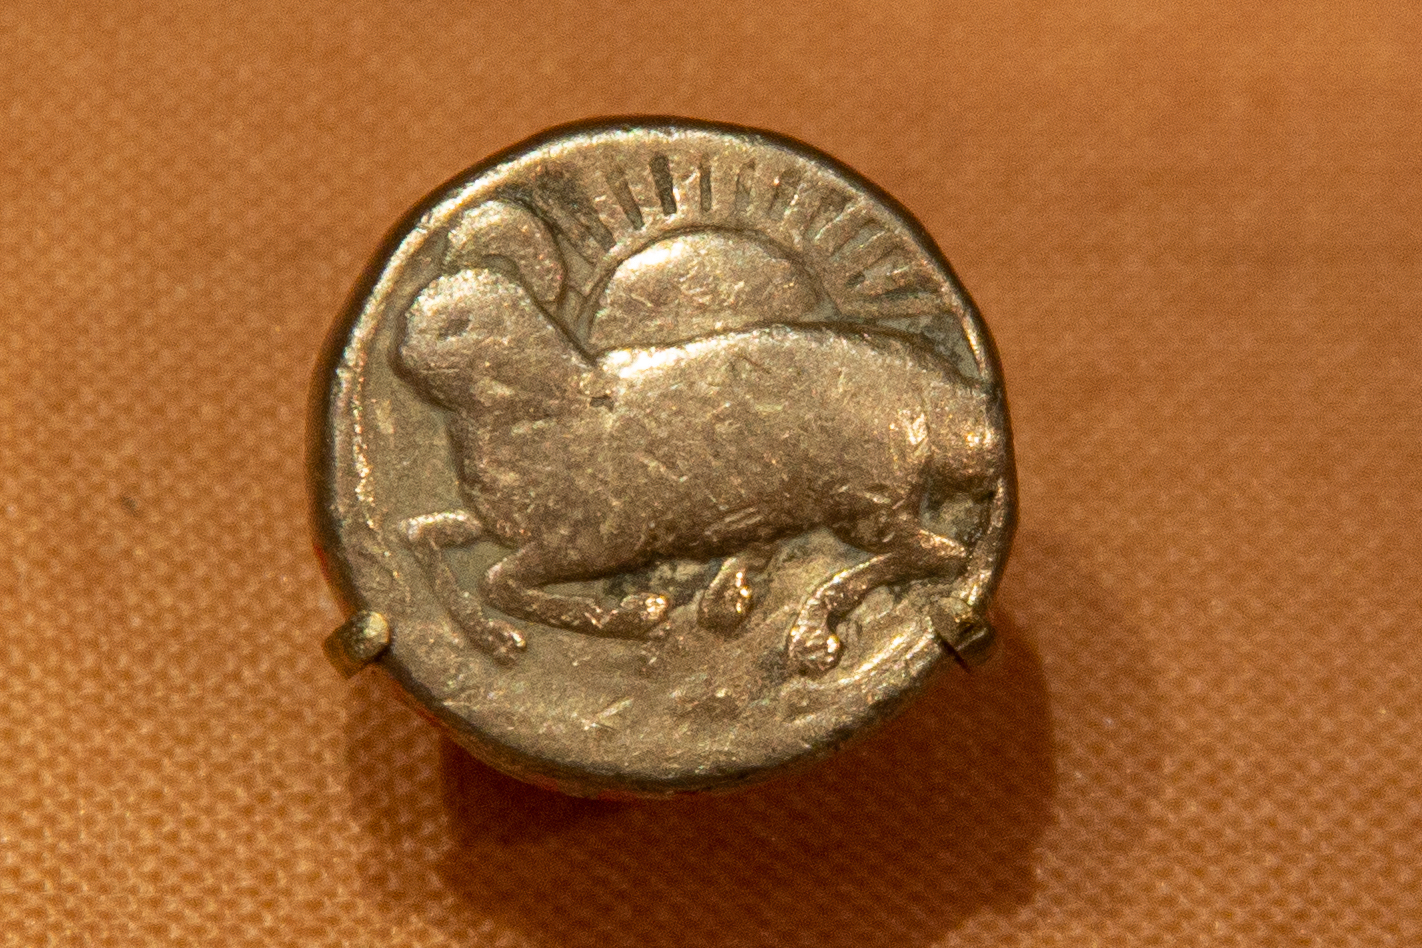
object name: coin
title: Group of Zodiac Coins--Aries, Leo, Pisces, Taurus, Capricorn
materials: silver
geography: india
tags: zodiac